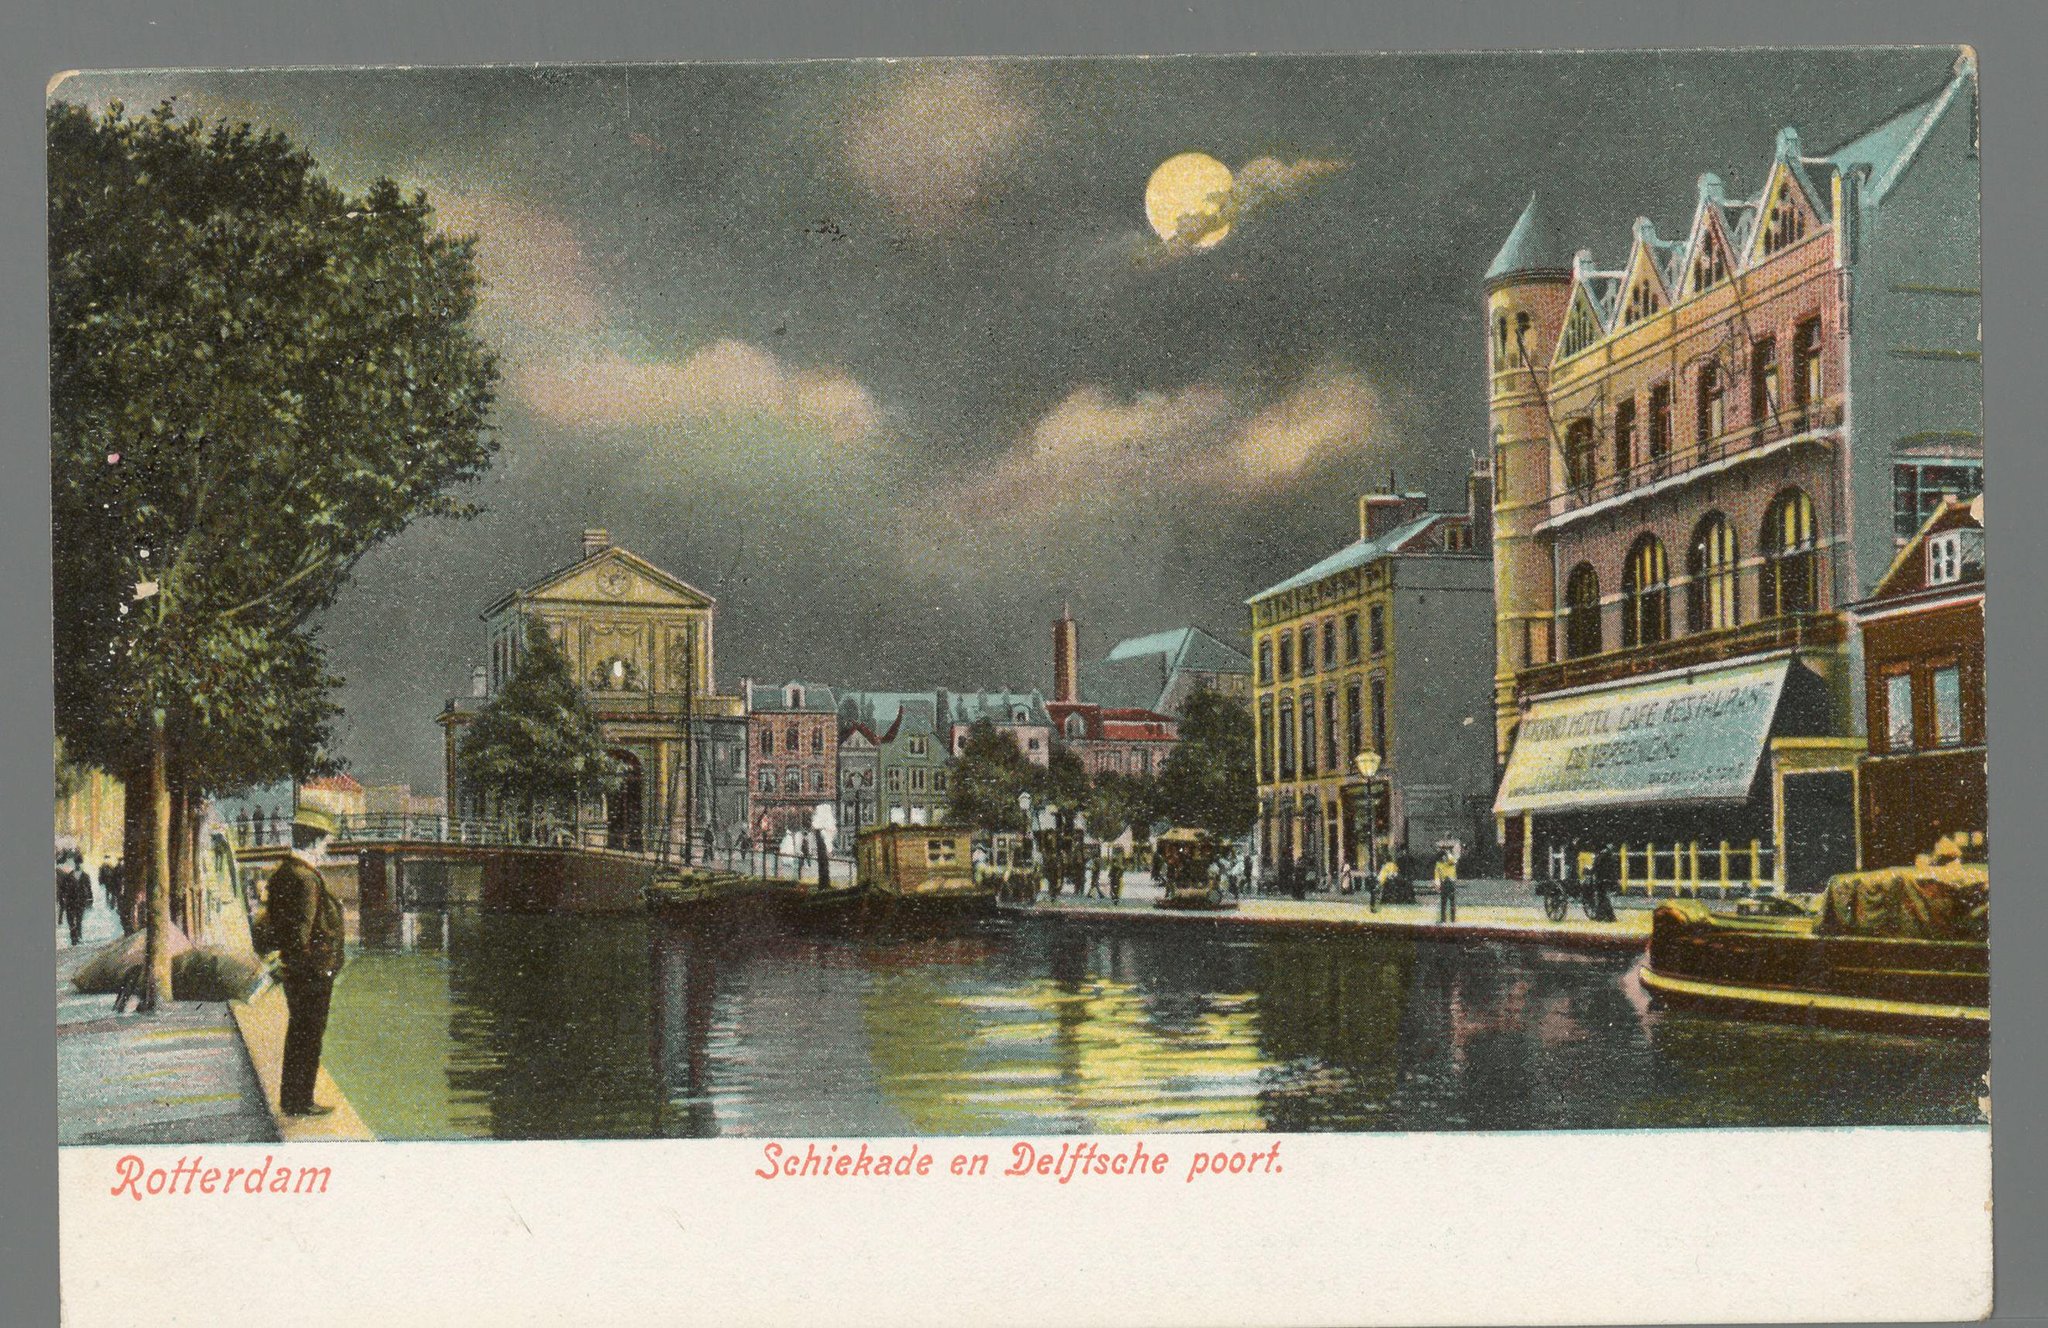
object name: photomechanical print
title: Rotterdam. Schiekade en Delftsche poort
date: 1897-1905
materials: cardboard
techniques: lithograph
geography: rotterdam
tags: canals, waters (in city), street, city-gate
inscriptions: stamp: ‘A.K.O.’